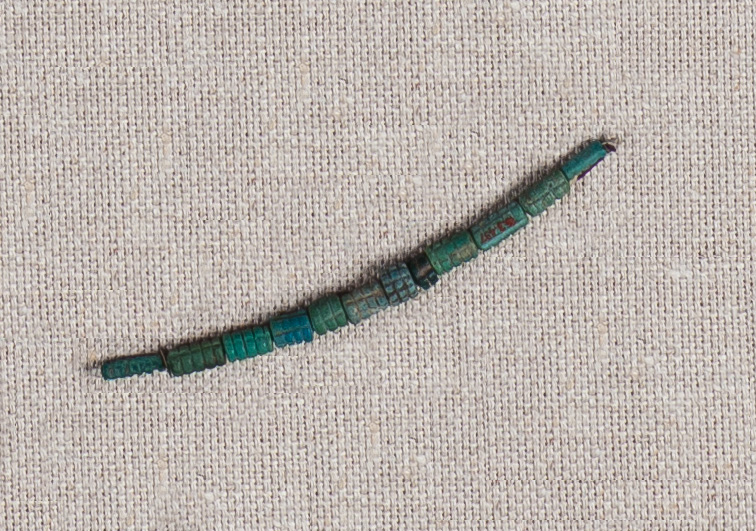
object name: necklace, bead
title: Necklace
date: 1981-1295 BCE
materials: faience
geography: egypt